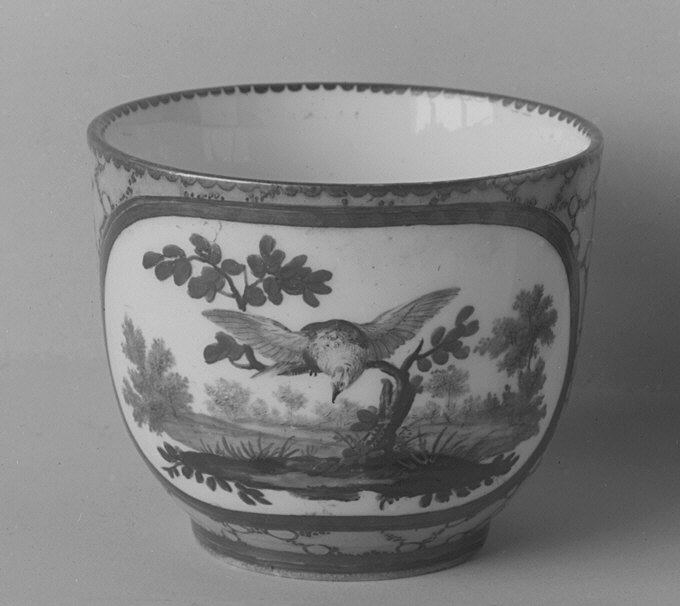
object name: cup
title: Cup with handle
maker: sèvres manufactory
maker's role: manufactory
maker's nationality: french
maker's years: 1740-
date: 1760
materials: soft paste porcelain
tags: birds,trees